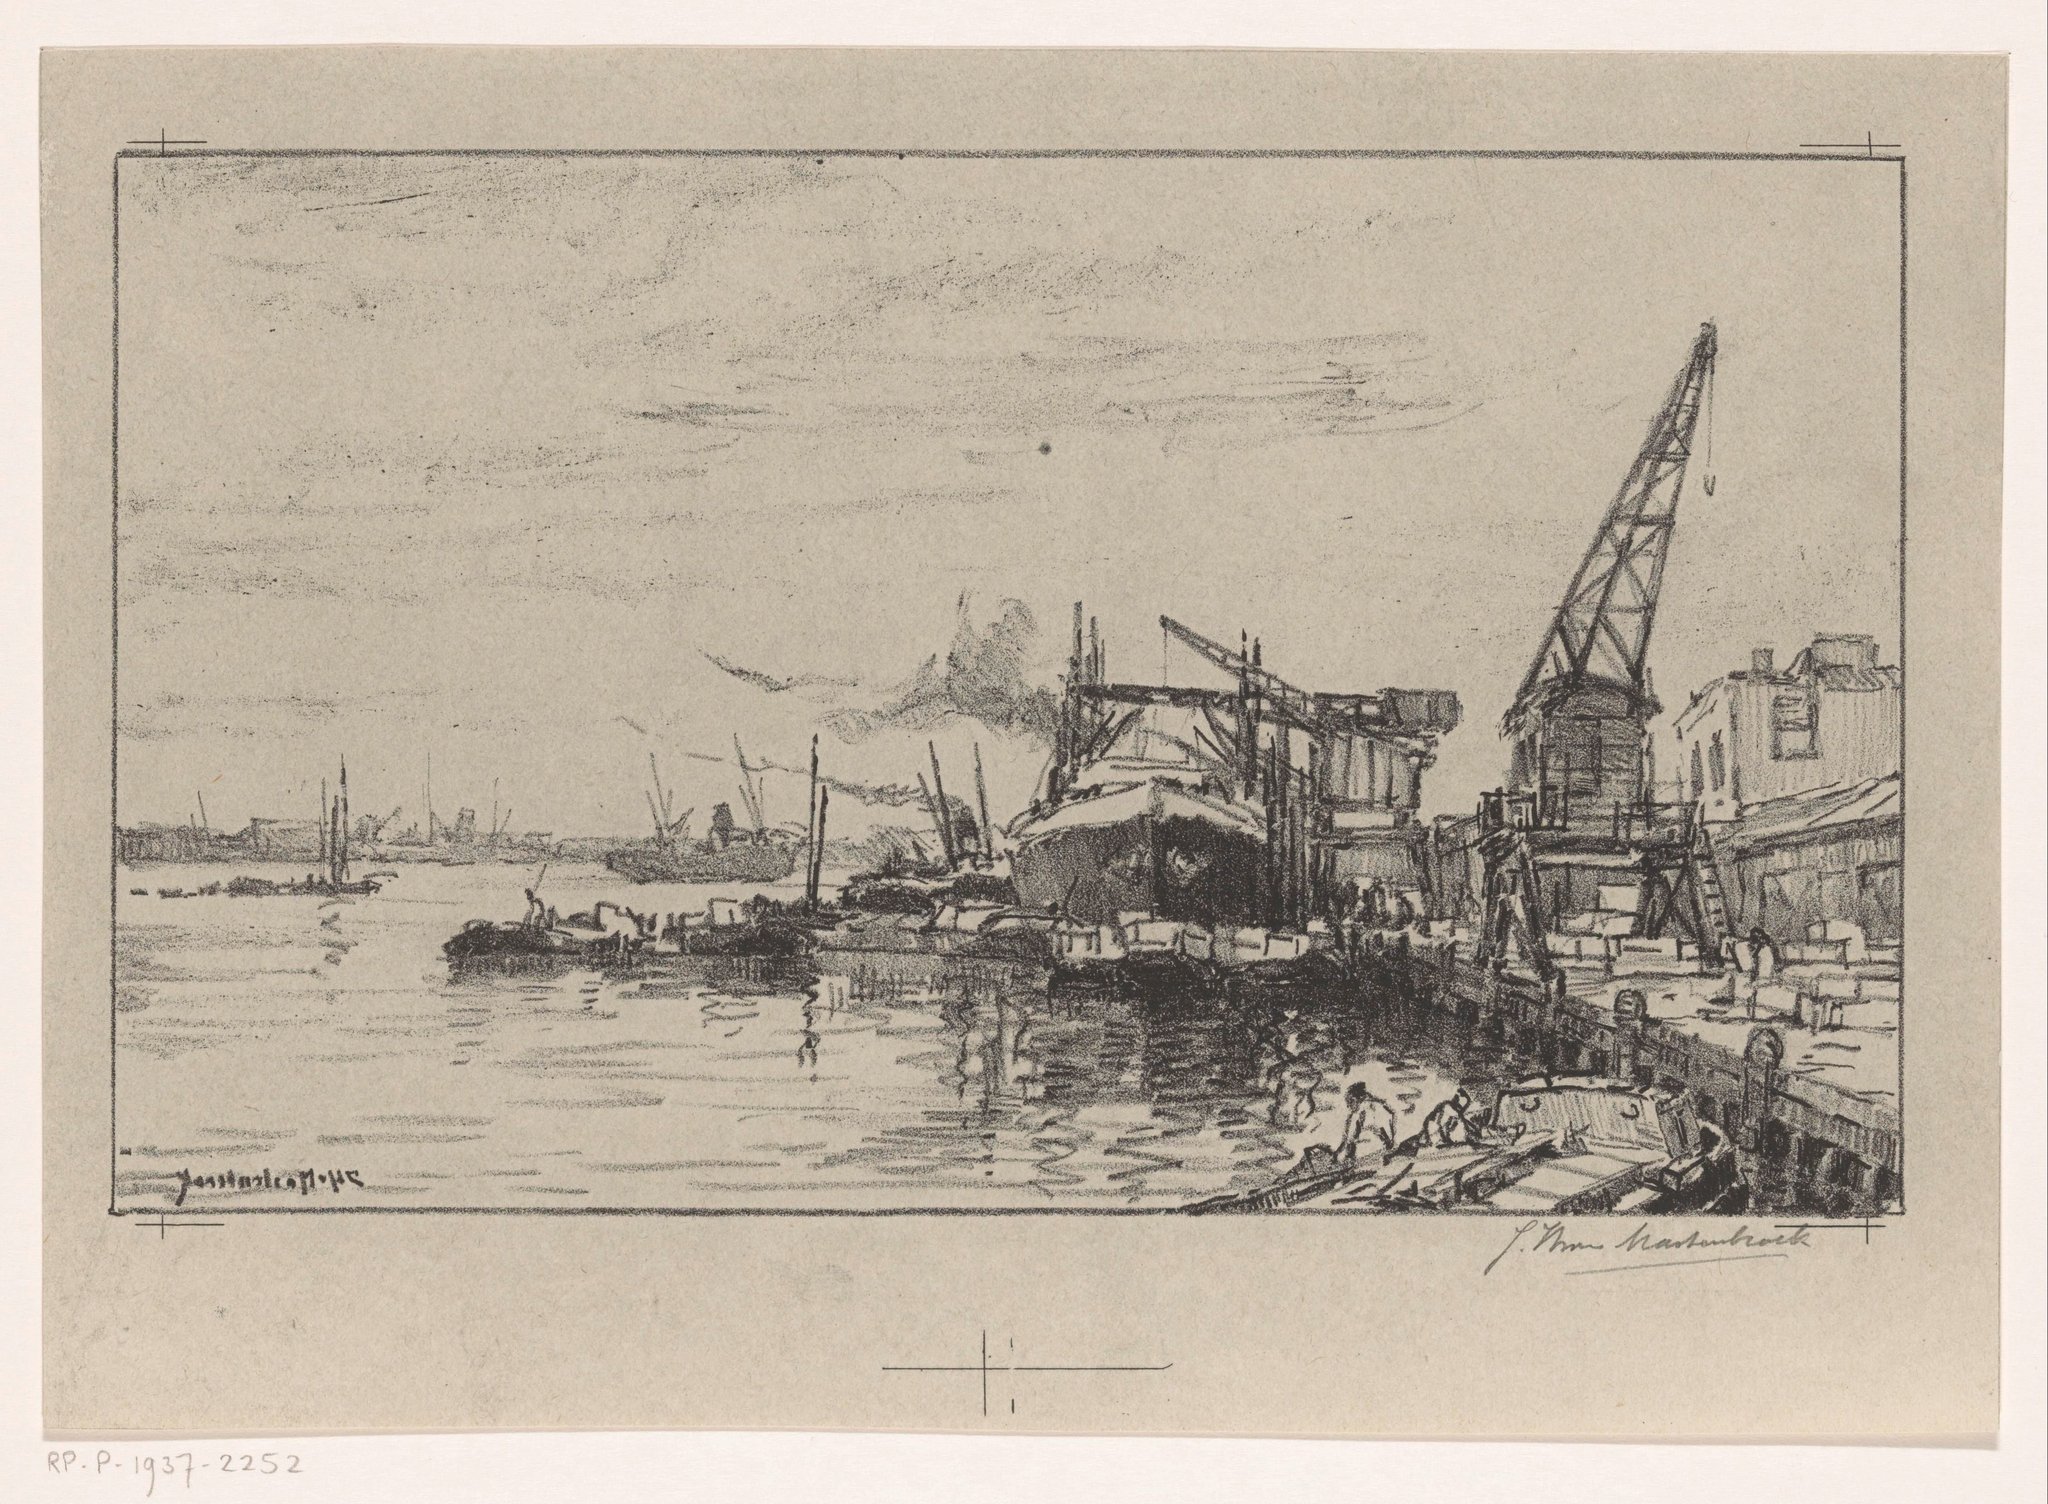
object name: print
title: Havengezicht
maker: johan hendrik van mastenbroek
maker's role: painter, print maker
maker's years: 1875-1945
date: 1885-1937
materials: paper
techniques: lithograph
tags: harbour, dock crane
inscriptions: collector's mark: Lugt 2760, collector's mark: Lugt 2228